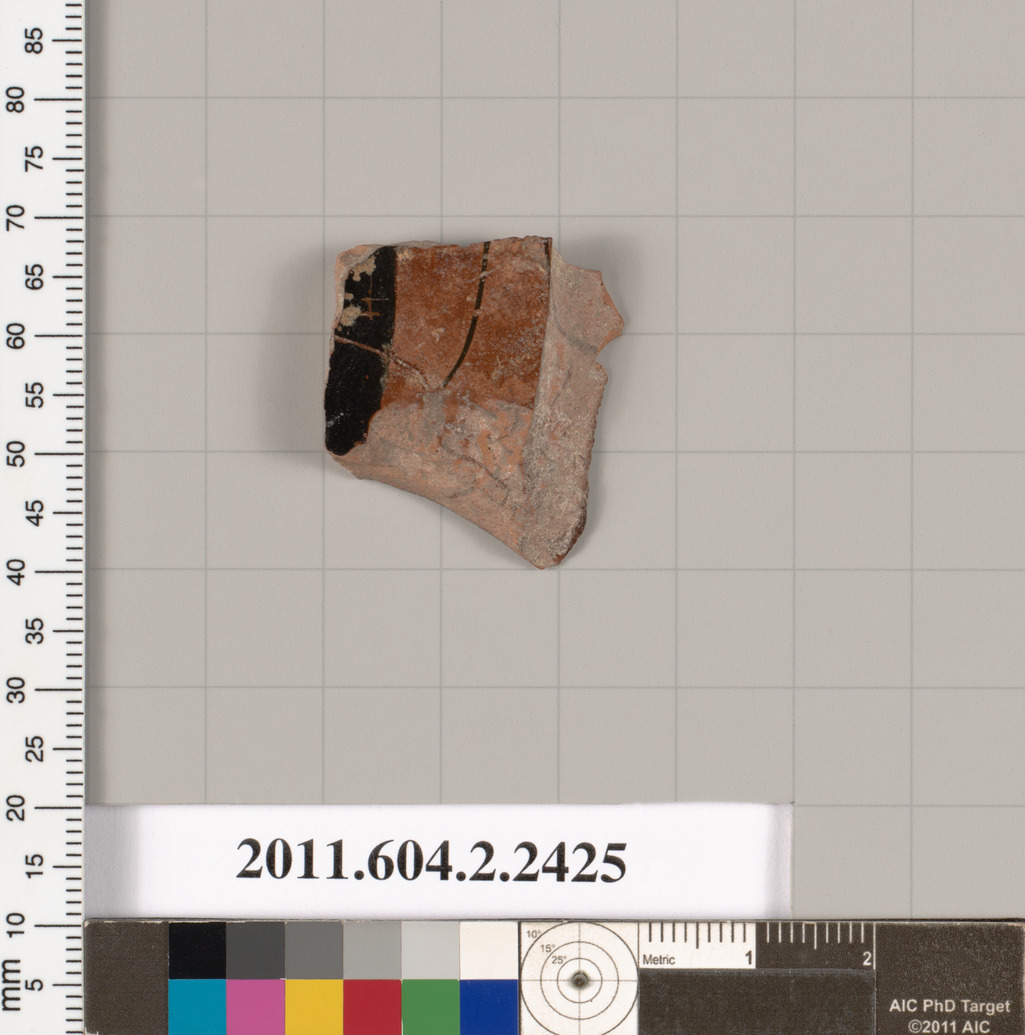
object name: undetermined closed shape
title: Terracotta fragment of a closed shape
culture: greek, attic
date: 480-470 BCE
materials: terracotta